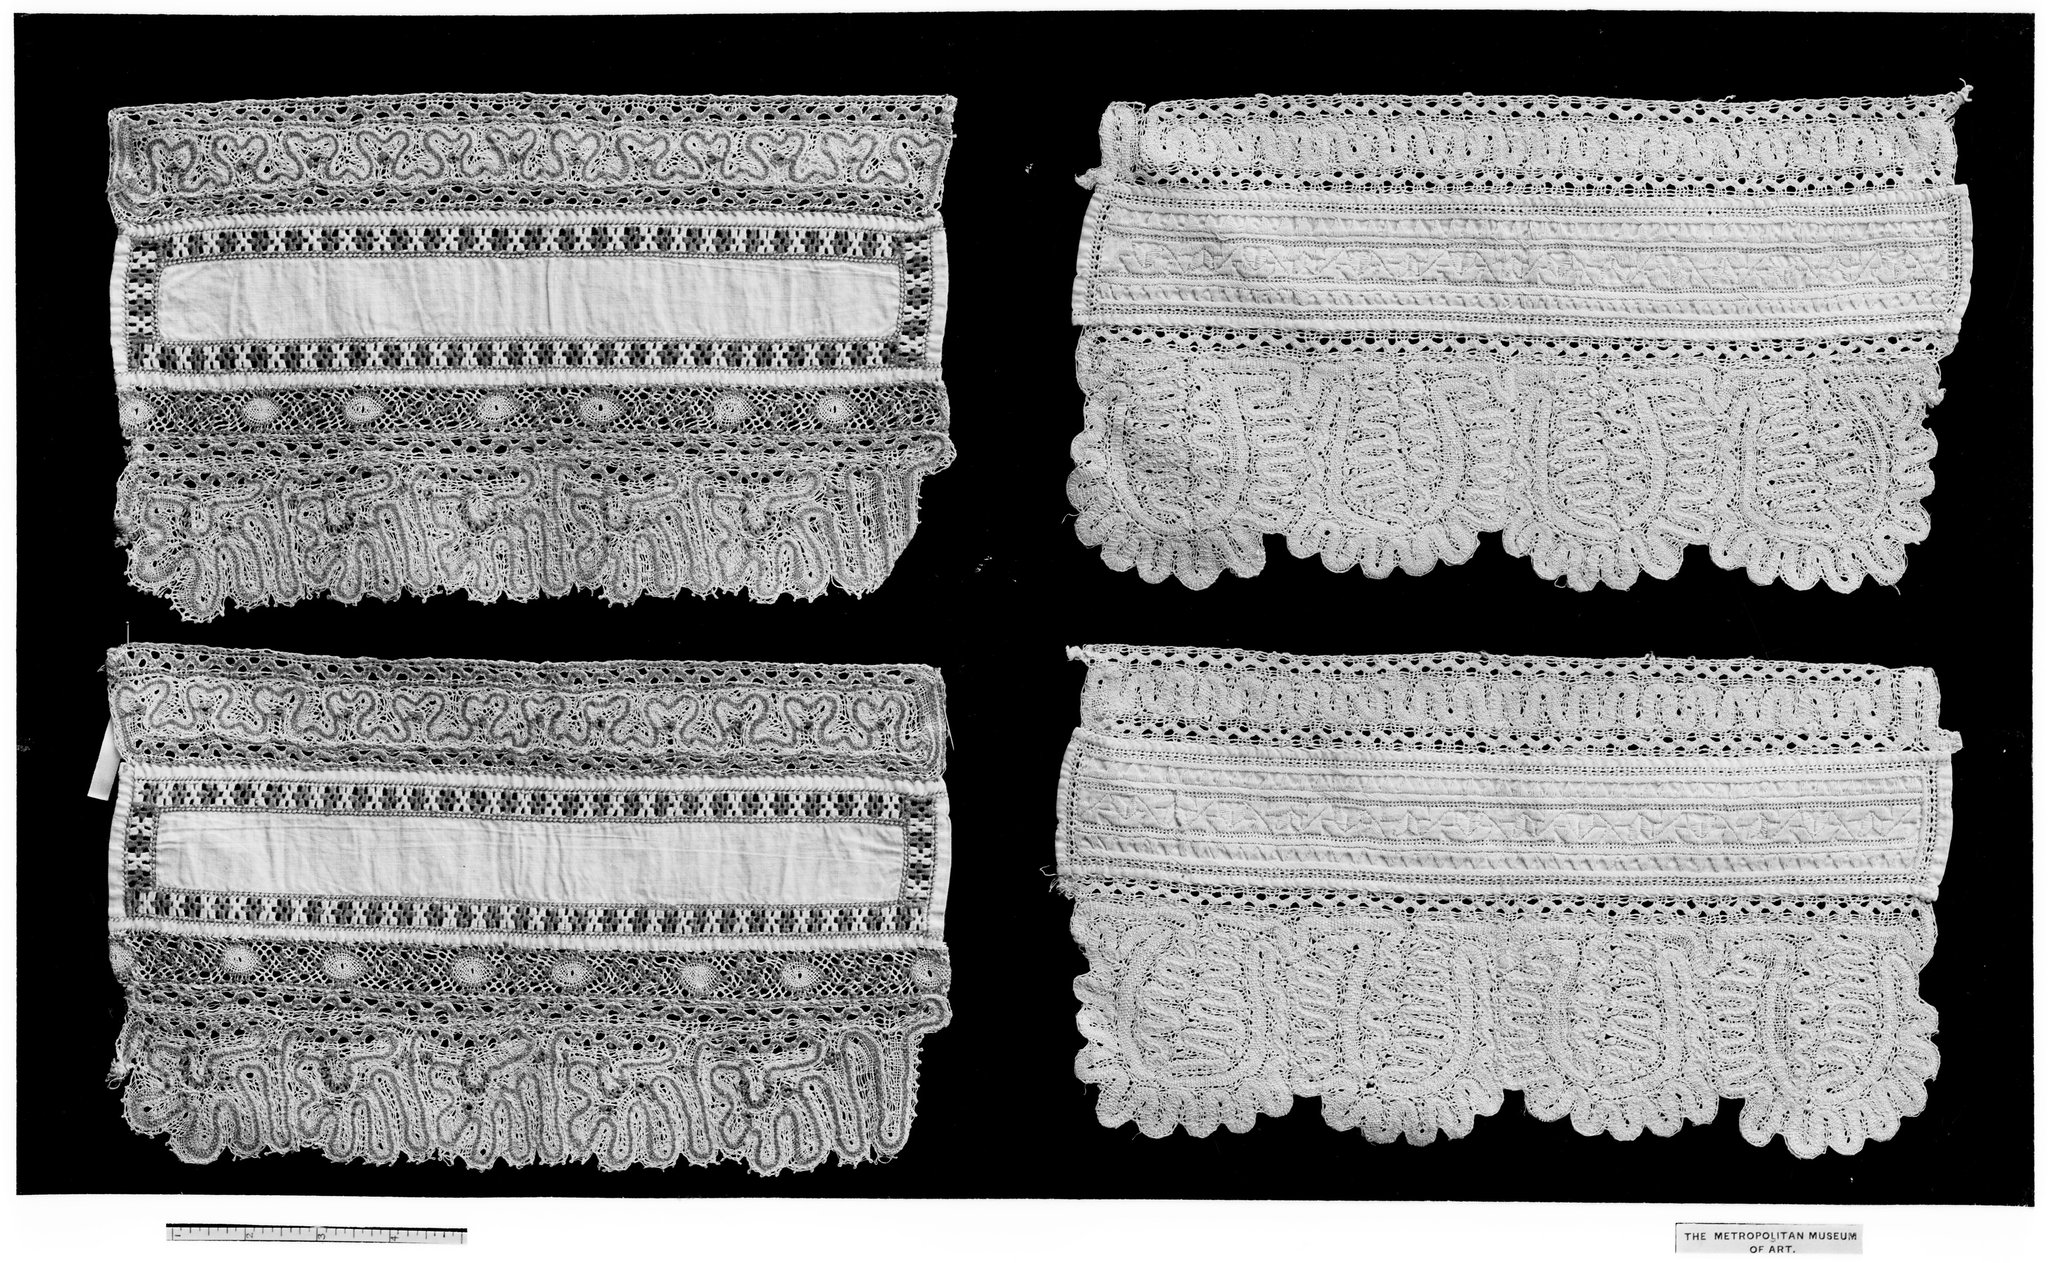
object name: cap fragment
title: Detail from a cap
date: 1834-1866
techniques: lace